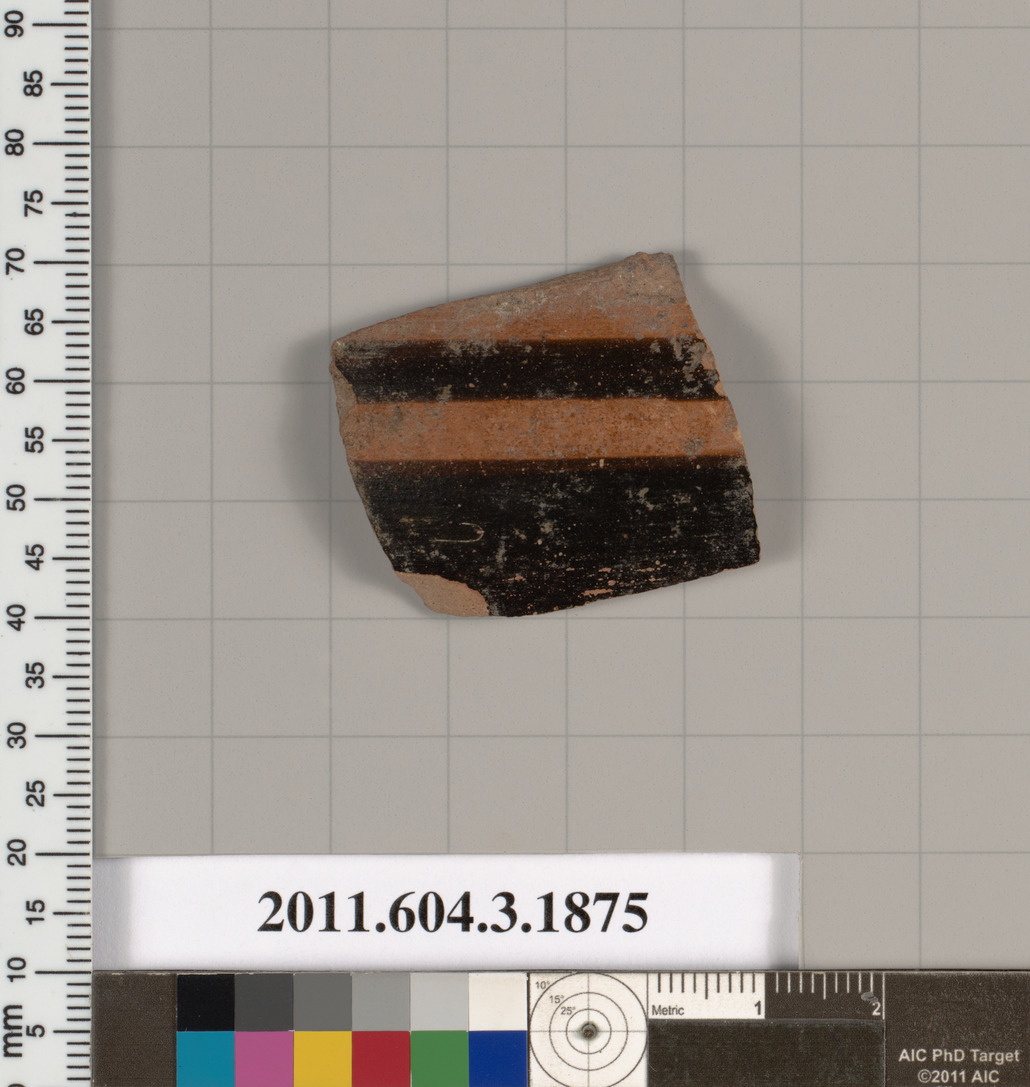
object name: kylix fragment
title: Terracotta fragment of a kylix: Band or lip cup (drinking cup)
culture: greek, attic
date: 560-525 BCE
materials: terracotta